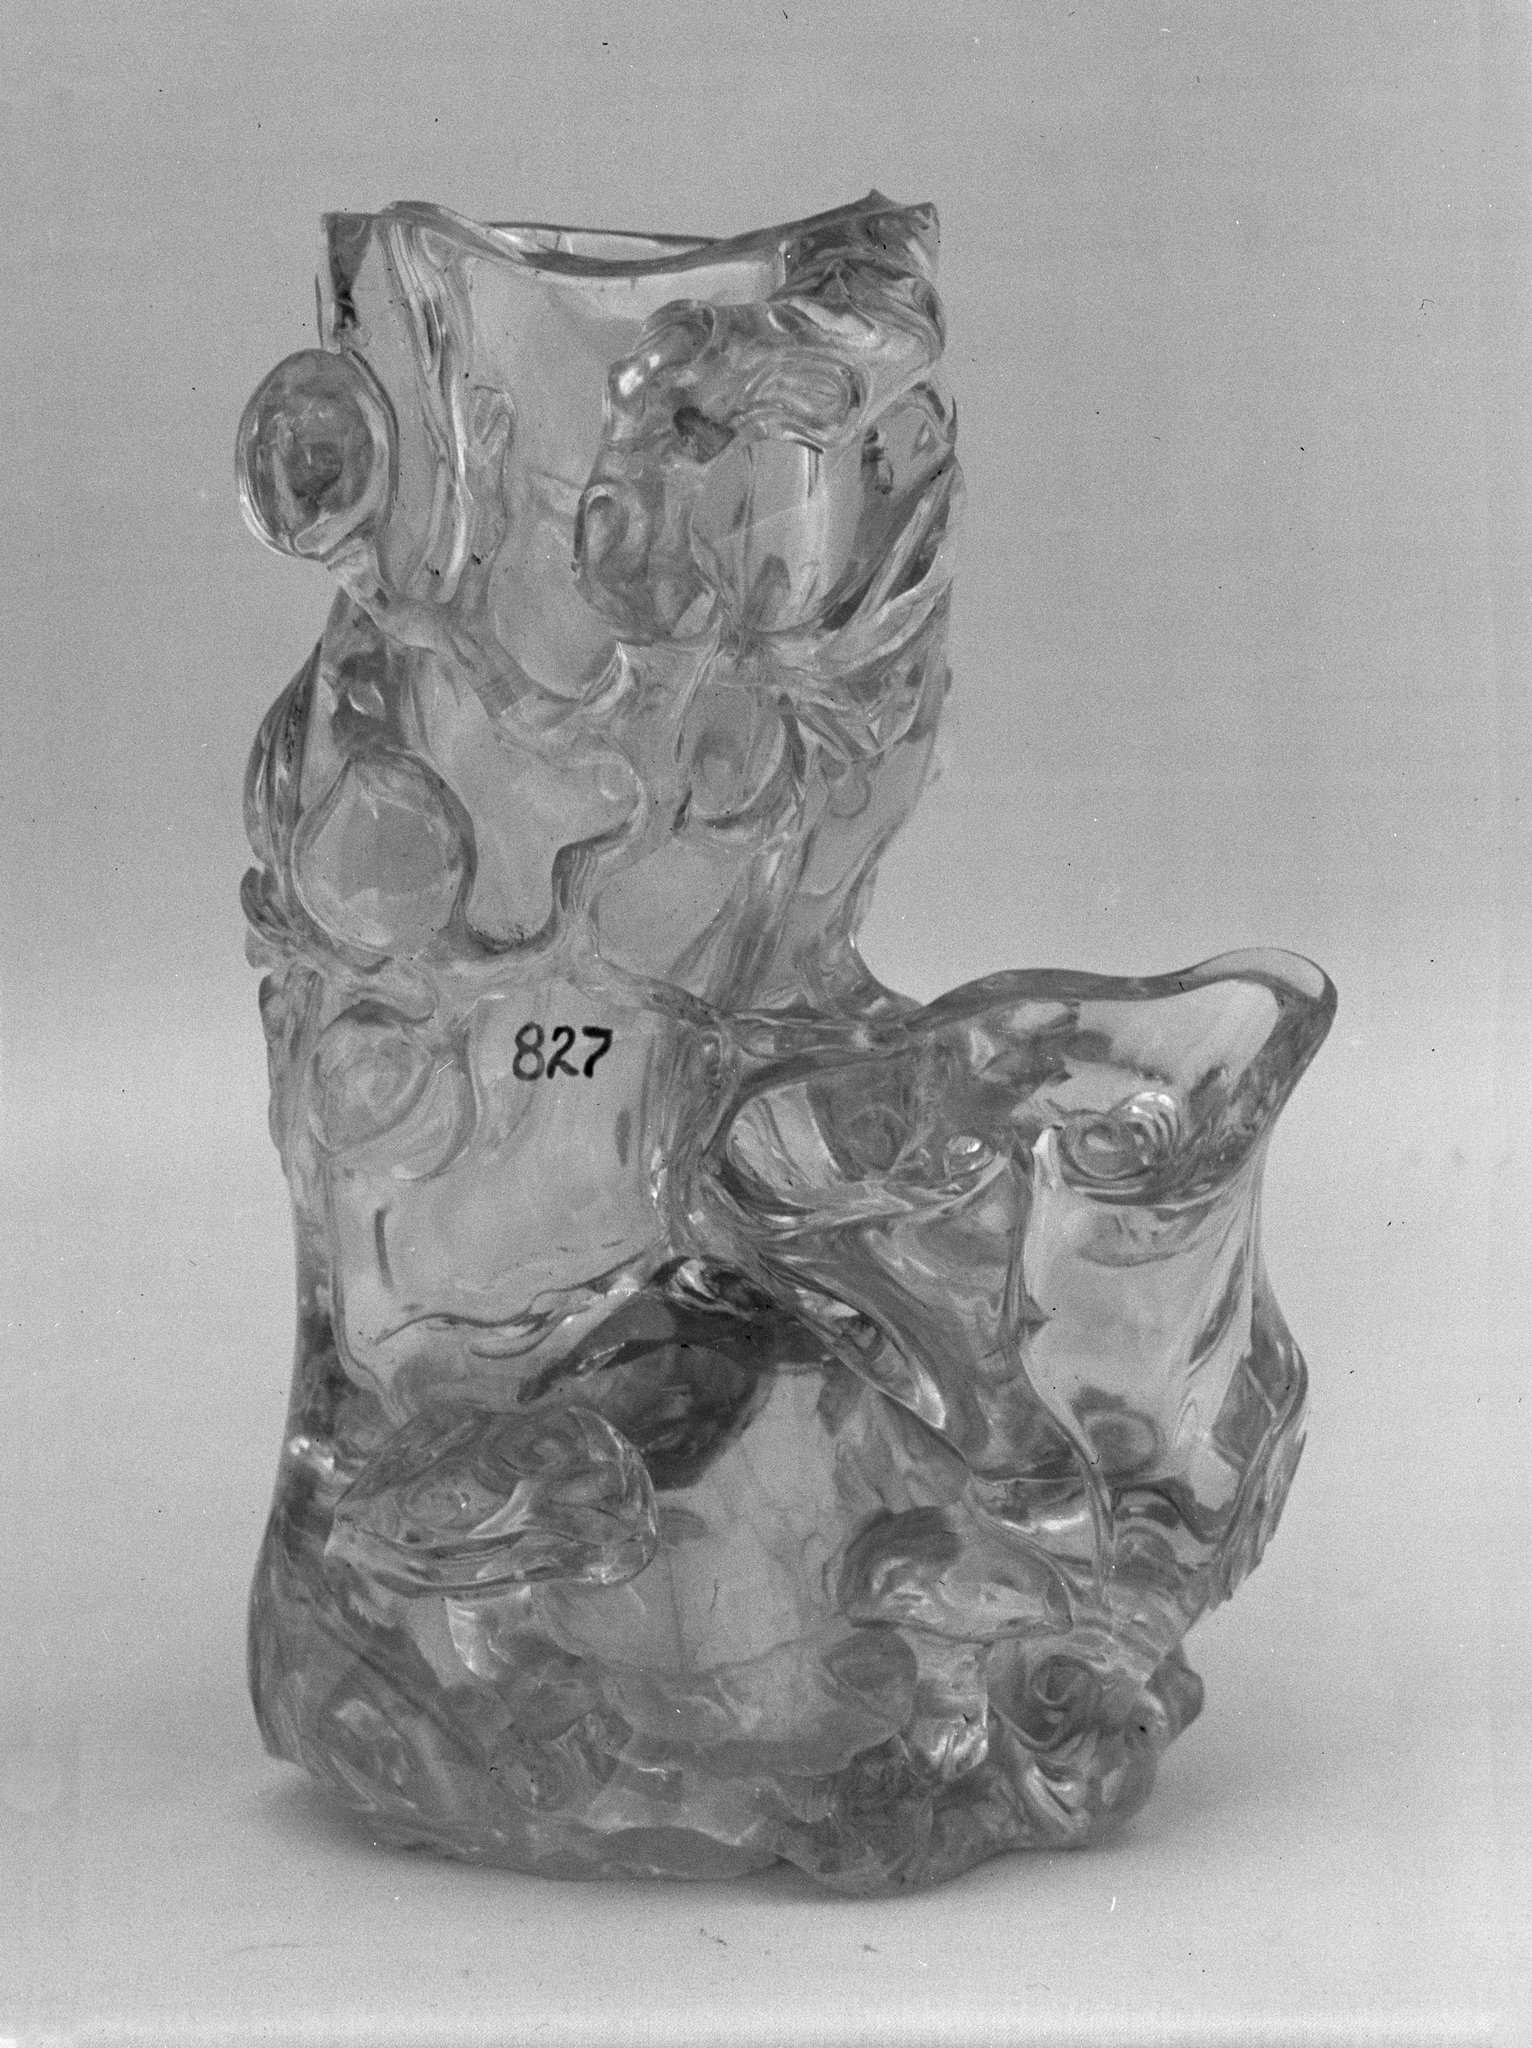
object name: double vase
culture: chinese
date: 1701-1800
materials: quartz